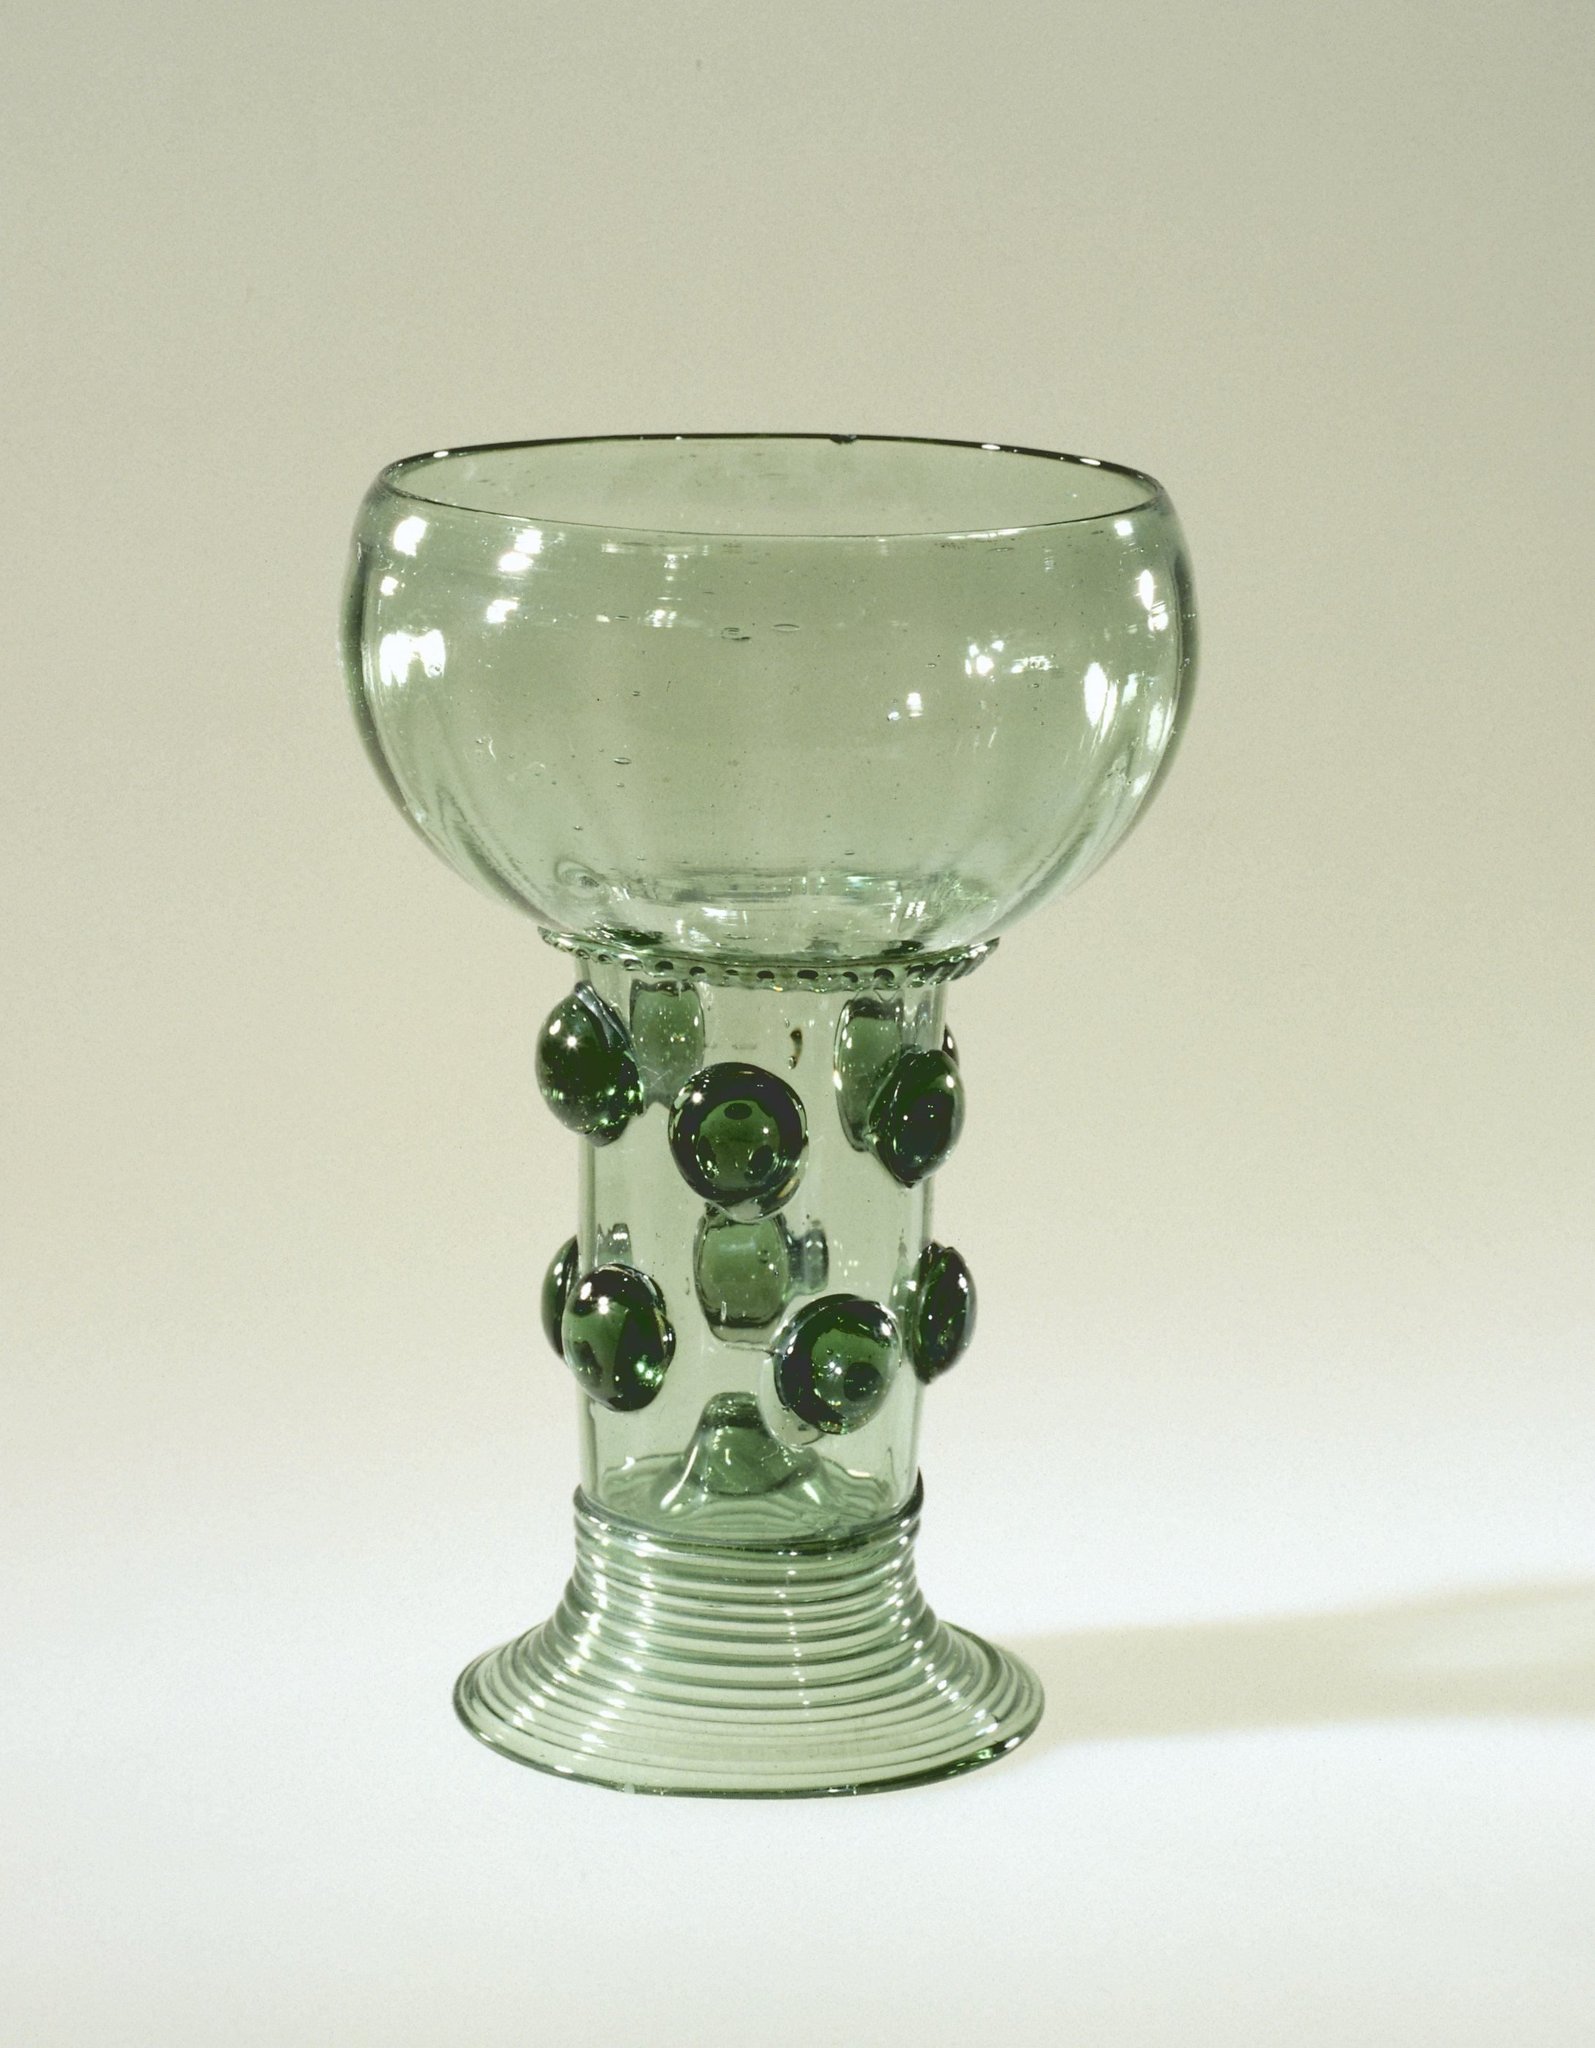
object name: roemer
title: Roemer met twee rijen gladde bolle noppen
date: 1650-1675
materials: glass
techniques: glassblowing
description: Hoge, concave gesponnen voet. Ingestoken bodem. Bolle, verticaal geribde kelk, als één geheel geblazen met de stam, die bezet is met twee rijen gladde, bolle noppen. De overgang van de kelk naar de stam aangegeven door een geribde draad.